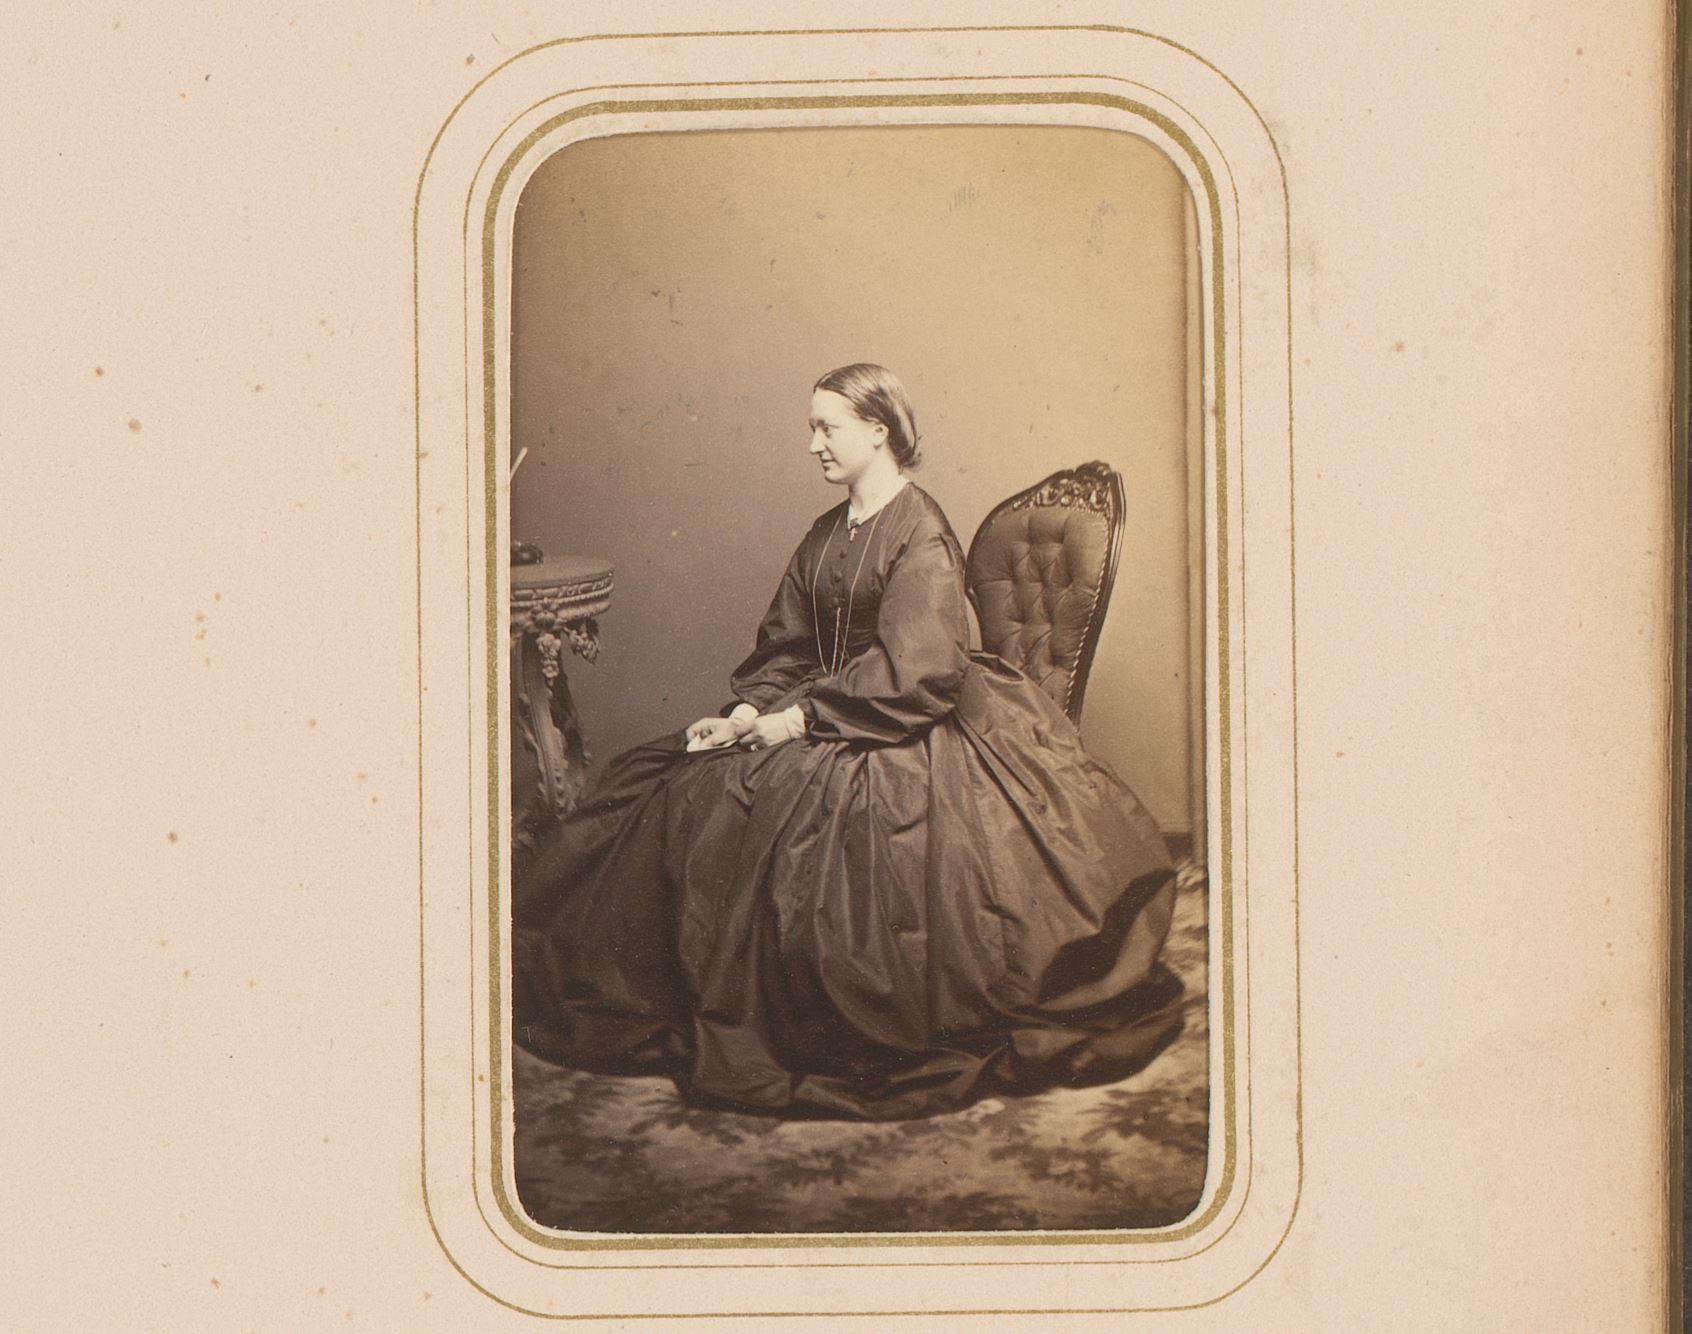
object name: album leaf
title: Portret van een zittende vrouw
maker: o.c. smith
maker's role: fotograaf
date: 1860-1900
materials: cardboard, photographic support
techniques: albumen print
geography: stroud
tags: sitting figure - aa - female human figure, historical persons - bb - woman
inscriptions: inscription: ‘O. C. SMITH/ LANDSDOWN/ STROUD/ NEGATIVES KEPT - COPIES CAN ALWAYS BE HAD’